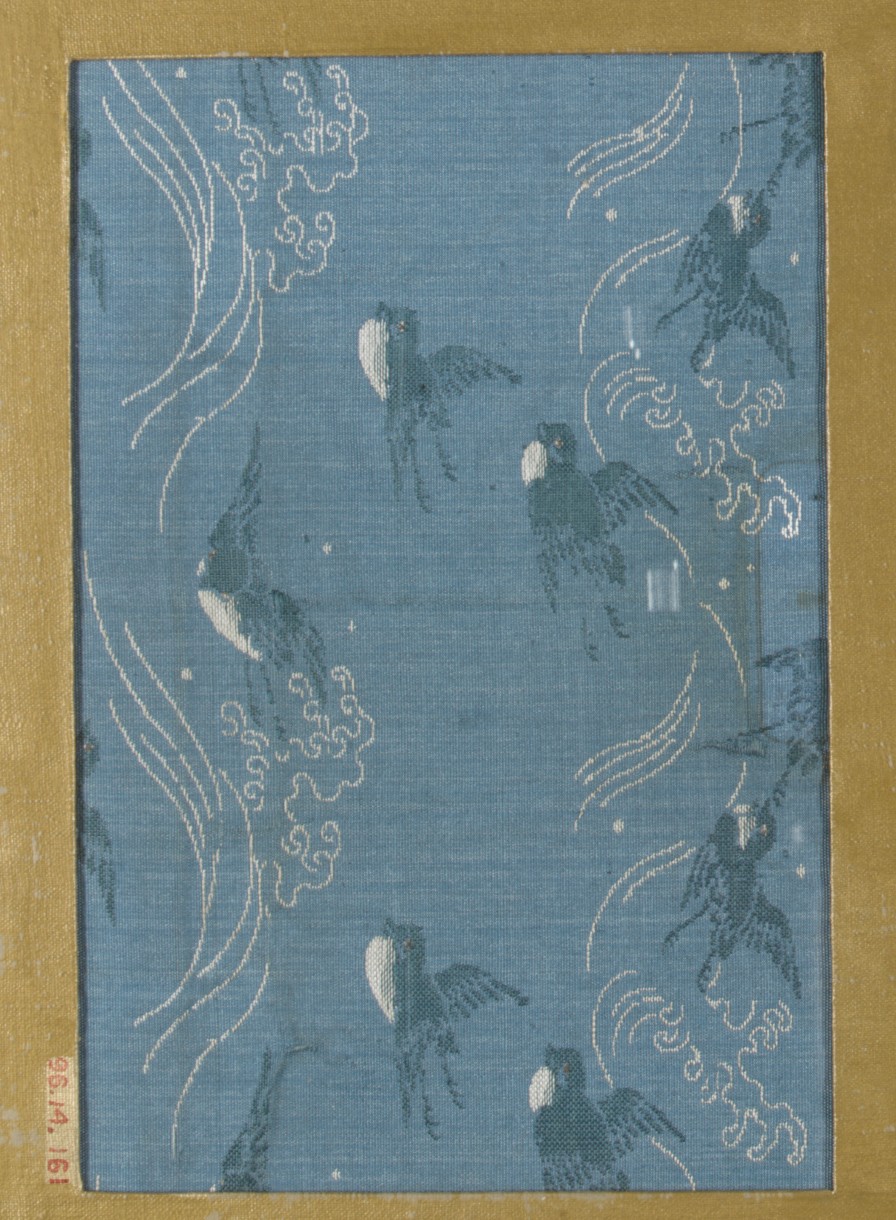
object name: fragment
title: Textile fragment with repeating pattern of waves and birds in flight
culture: japanese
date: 1701-1900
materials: silk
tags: birds